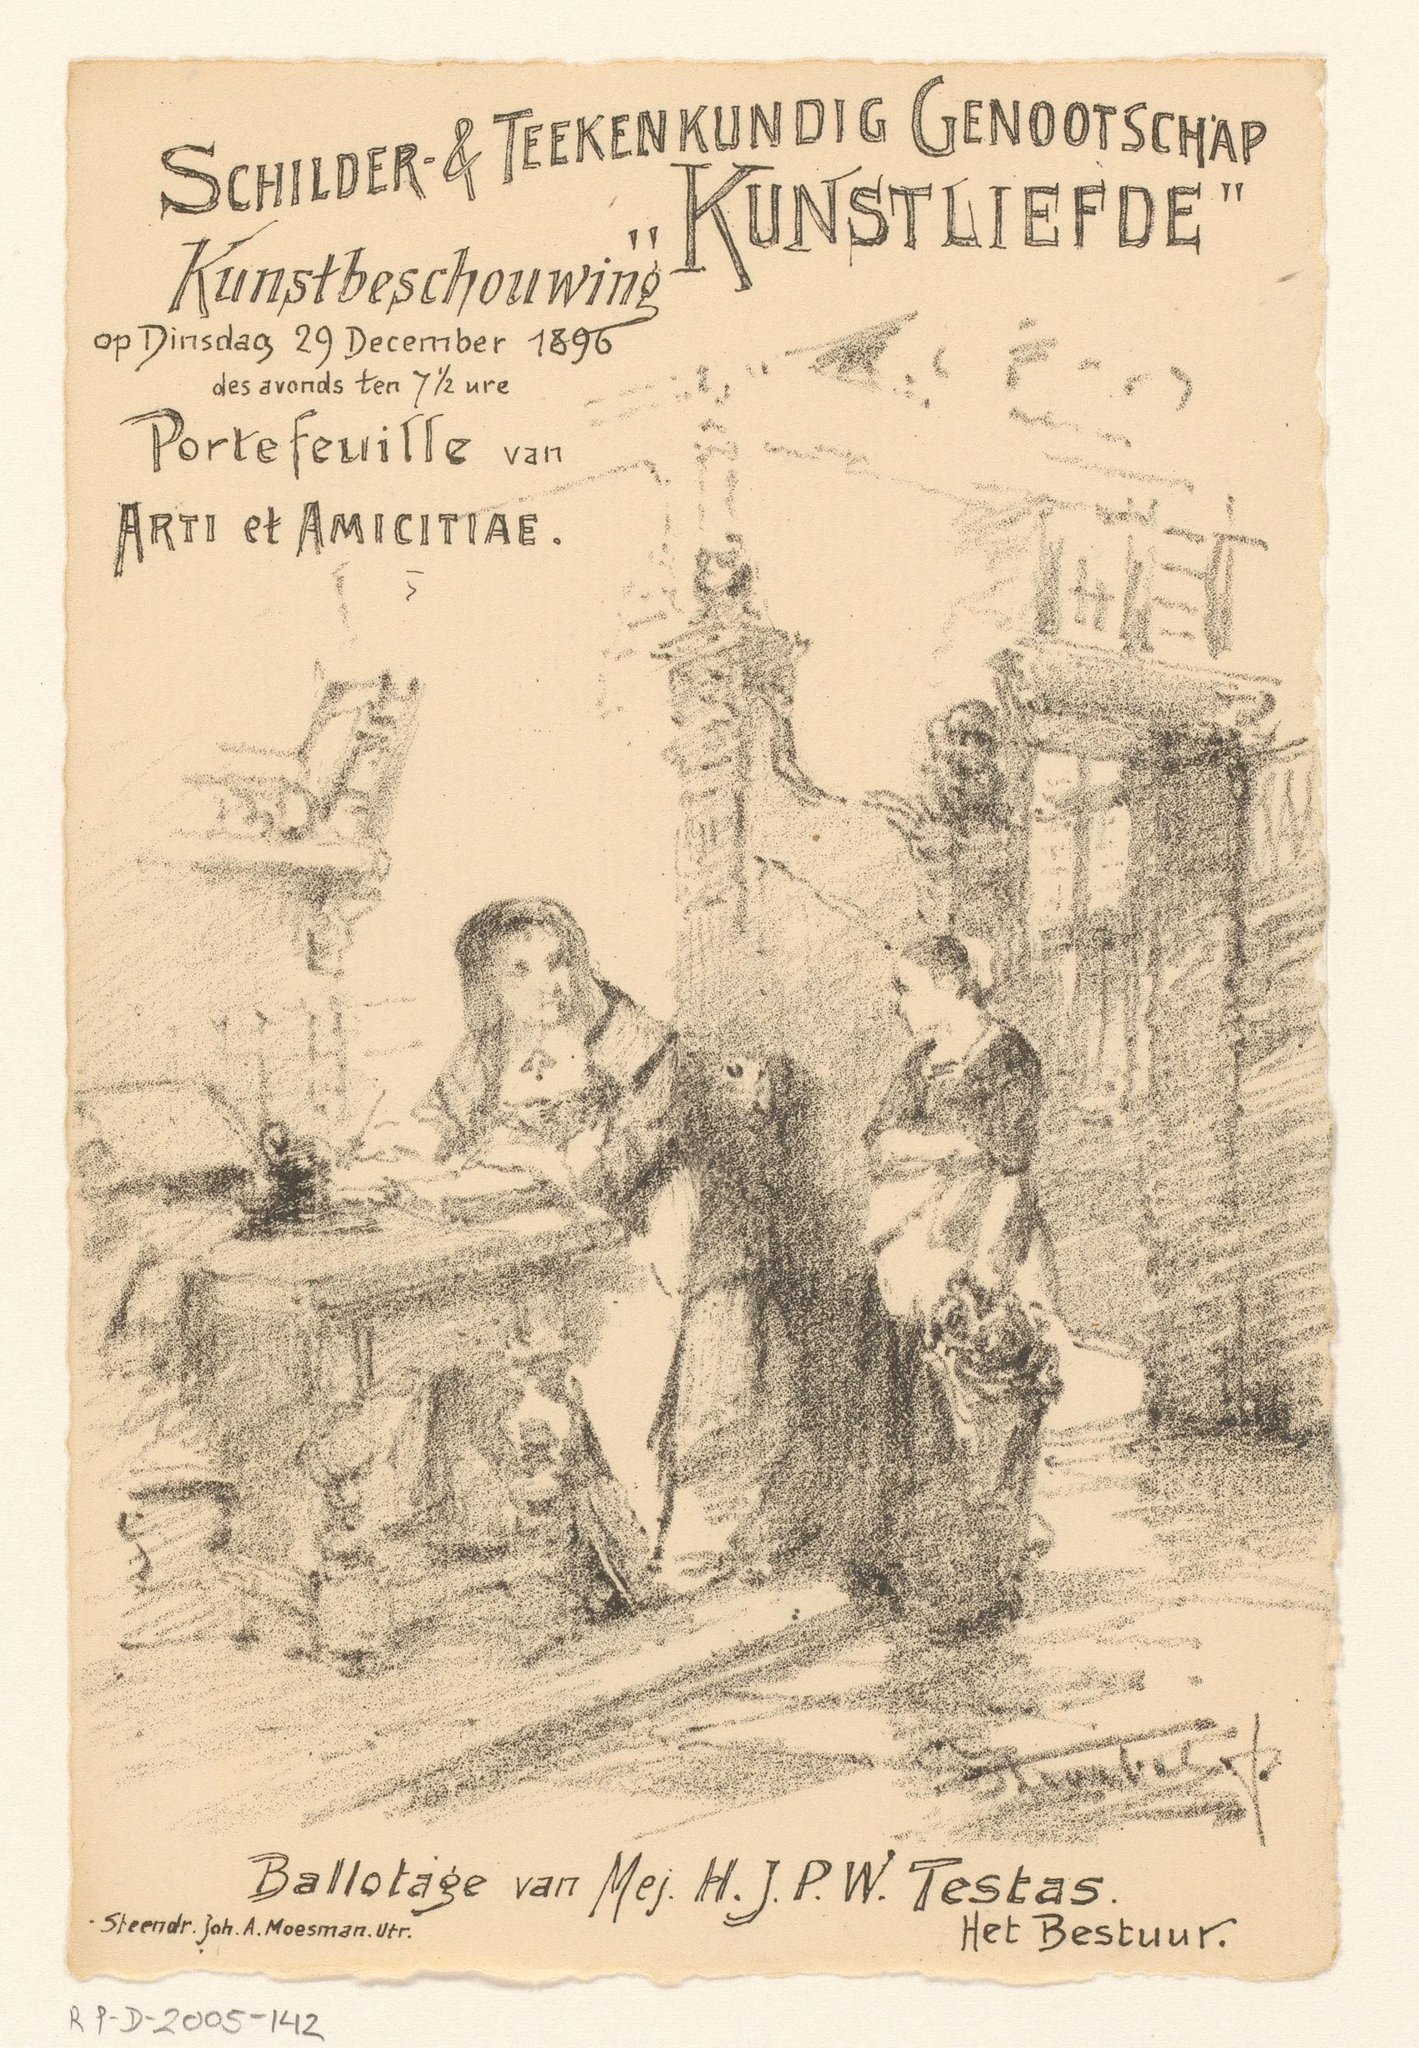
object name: invitation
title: Uitnodiging van Schilder- en Teekenkundig Genootschap "Kunstliefde" voor een kunstbeschouwing, 29 december 1896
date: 1812-1896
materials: paper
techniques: lithograph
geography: netherlands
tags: criticizing and discussing art, art criticism, circle, club of artists, collecting and exhibiting products of the fine arts, relation between master and servant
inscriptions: collector's mark: Lugt 2228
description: Interieur met een vrouw schrijvend aan een bureau en een staande dienstmeid. Uitnodiging van Schilder- en Teekenkundig Genootschap "Kunstliefde" voor een kunstbeschouwing op 29 december 1896 van de portefeuille van Arti et Amicitiae.